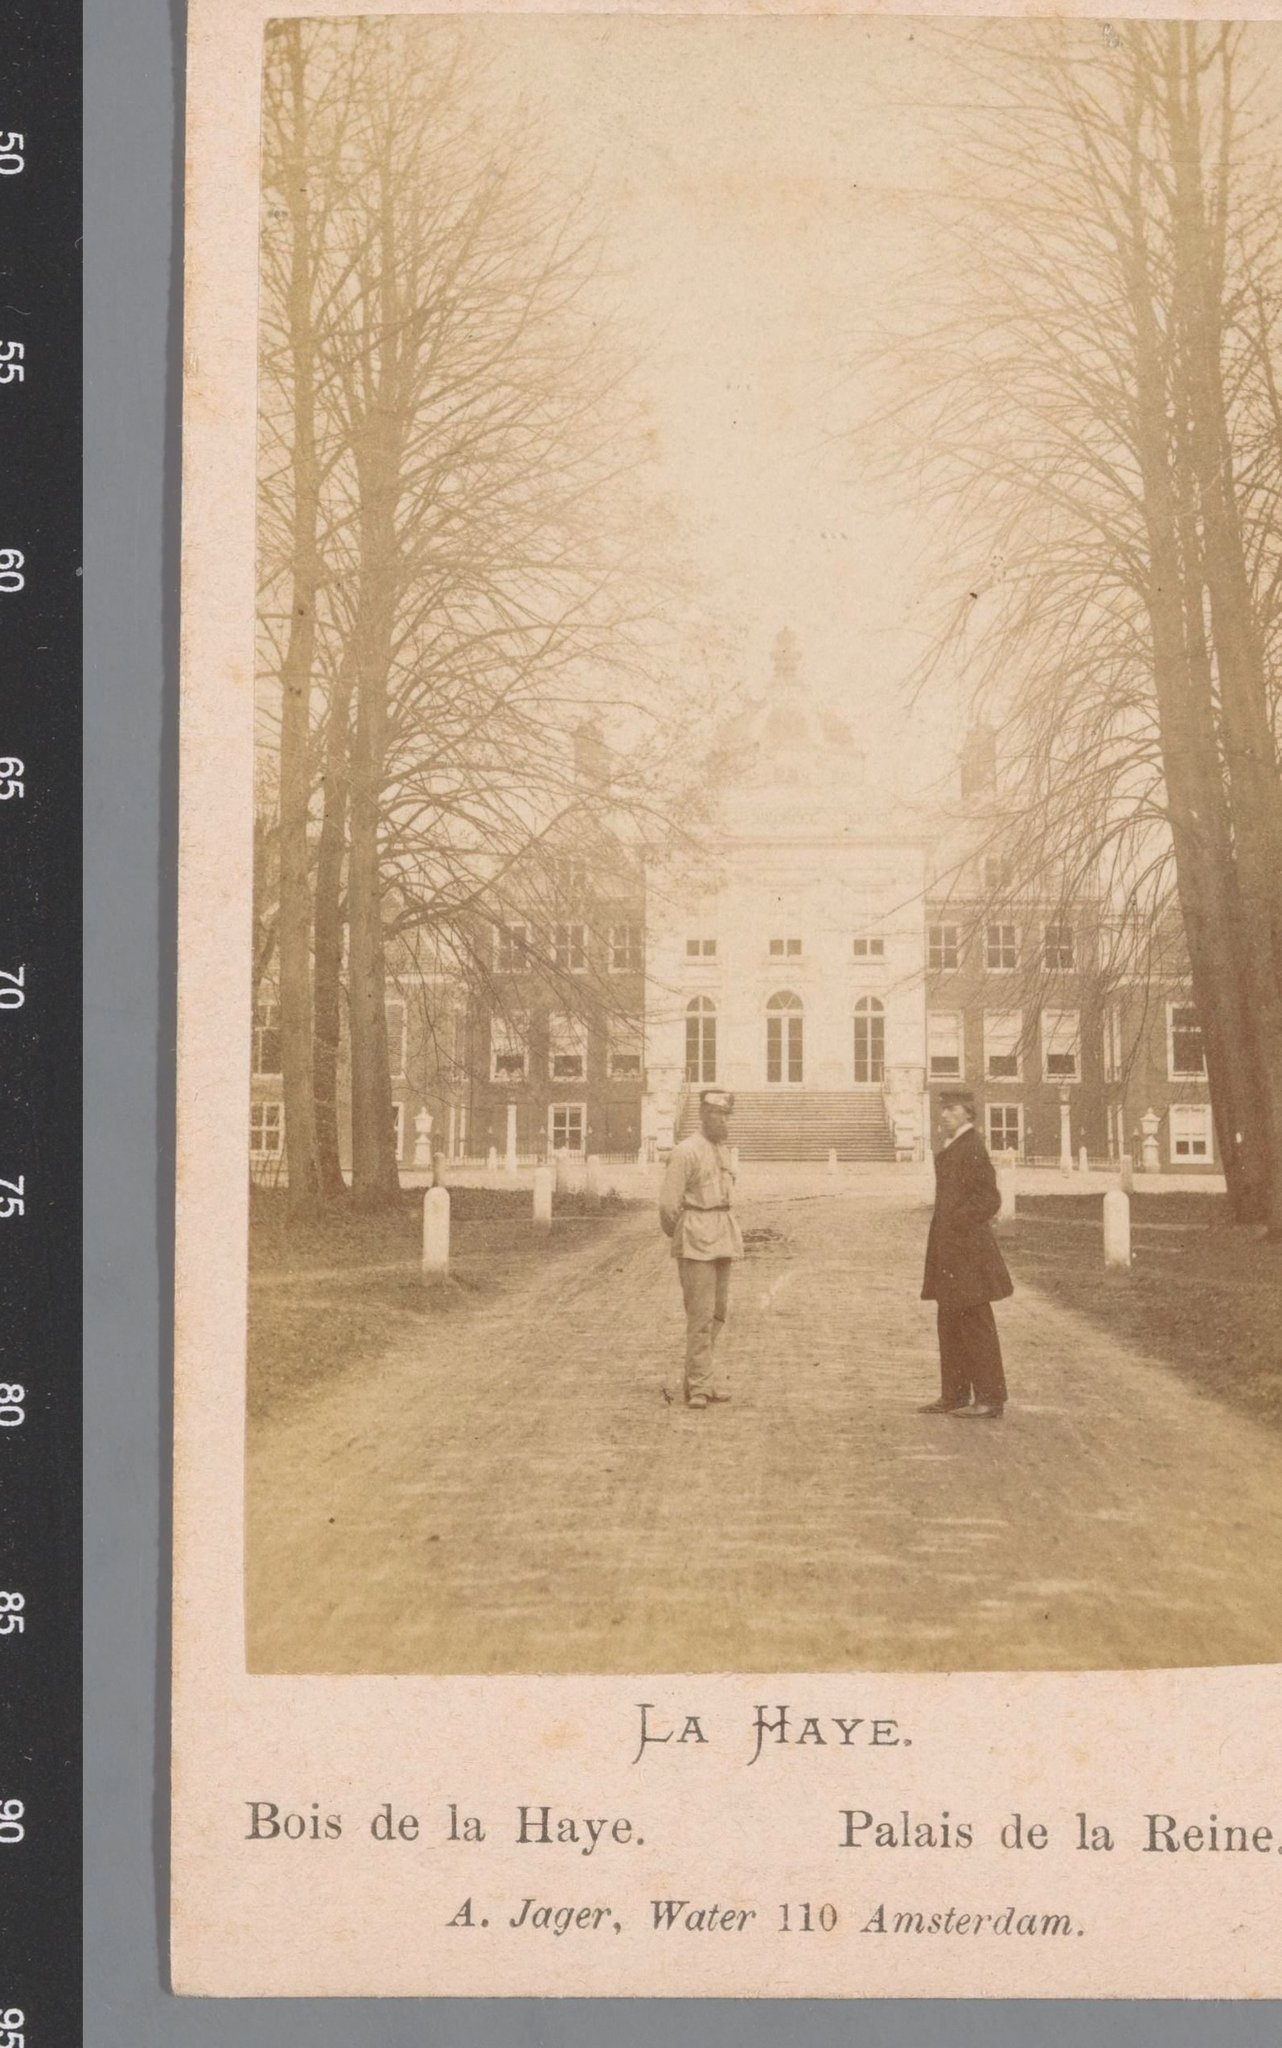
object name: carte de visite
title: Gezicht op paleis Huis ten Bosch in Den Haag, met twee mannen op de oprijlaan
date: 1860-1905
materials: cardboard, photographic support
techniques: albumen print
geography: amsterdam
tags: adult man (+ two persons), palace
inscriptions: number: ‘20,-’, inscription: ‘LA HAYE./ Bois de la Haye. Palais de la Reine./ A. Jager, Water 110 Amsterdam.’